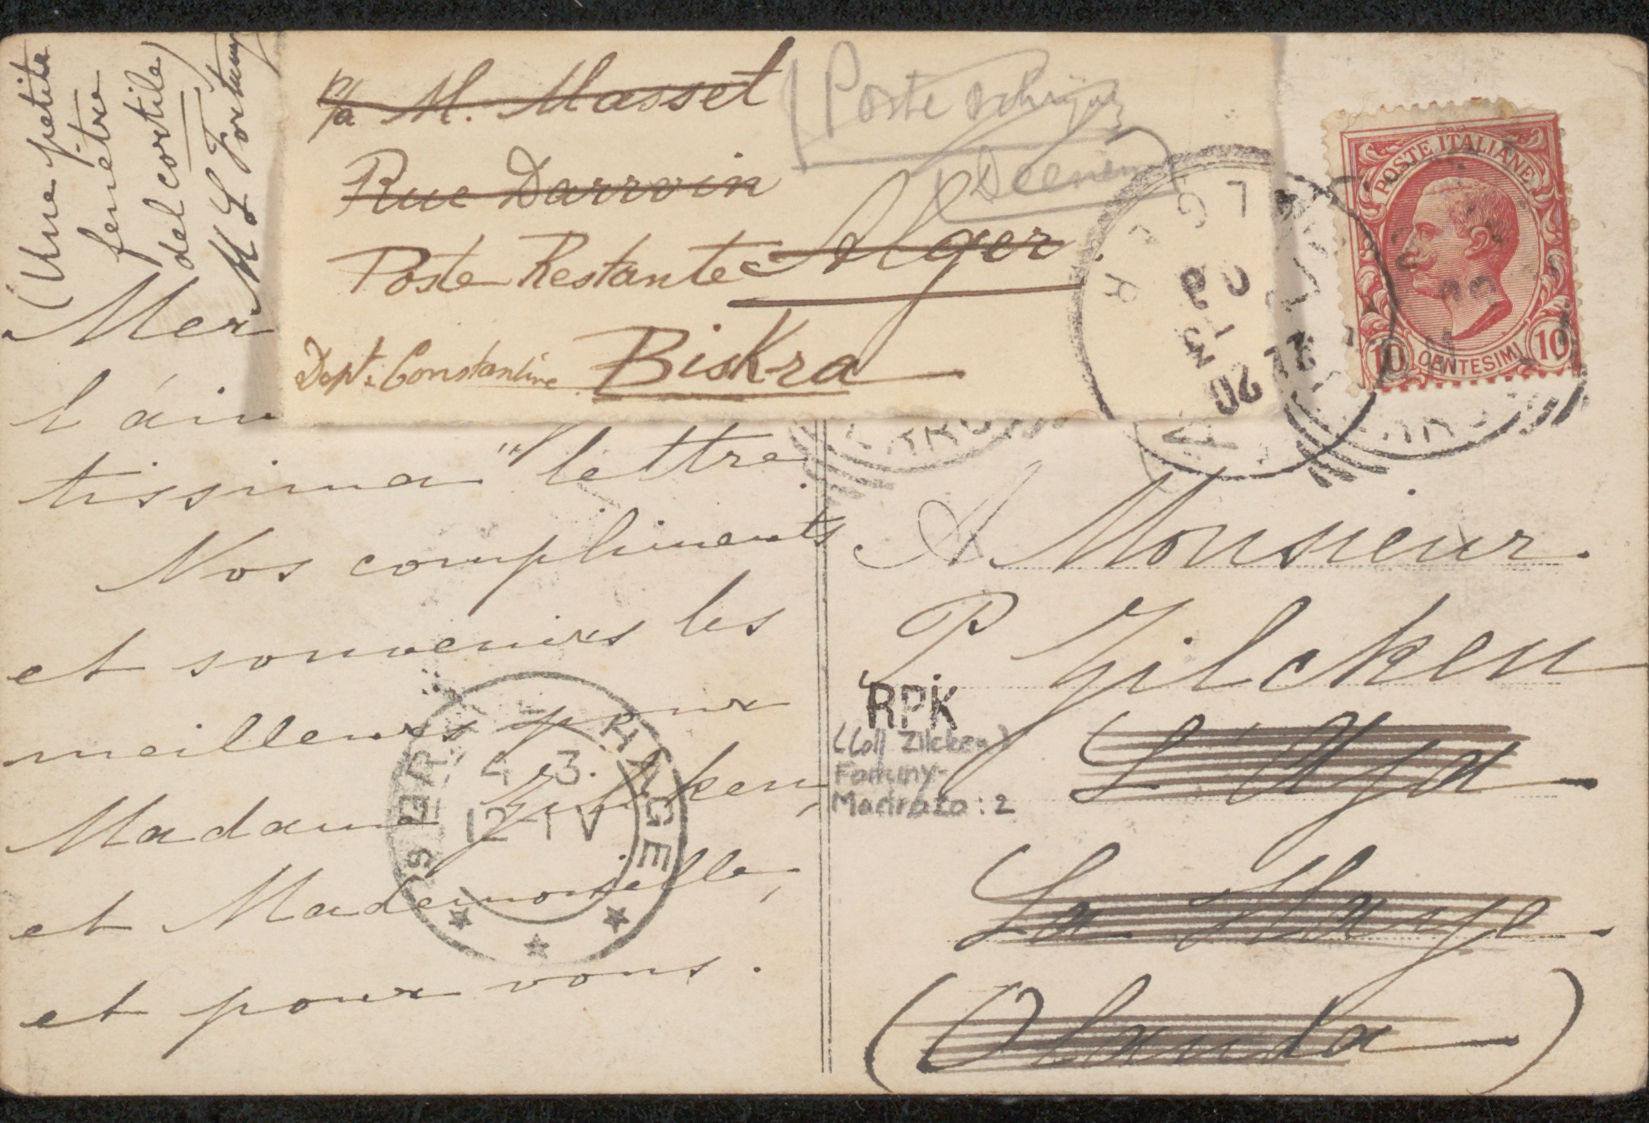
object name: ansichtkaart, prentbriefkaart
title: Prentbriefkaart aan Philip Zilcken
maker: cecilia de madrazo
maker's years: 1846-1932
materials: cardboard, ink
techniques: gelatin silver print, pen, writing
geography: venice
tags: the hague, painter, draughtsman, philip zilcken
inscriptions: collector's mark: ‘RPK’